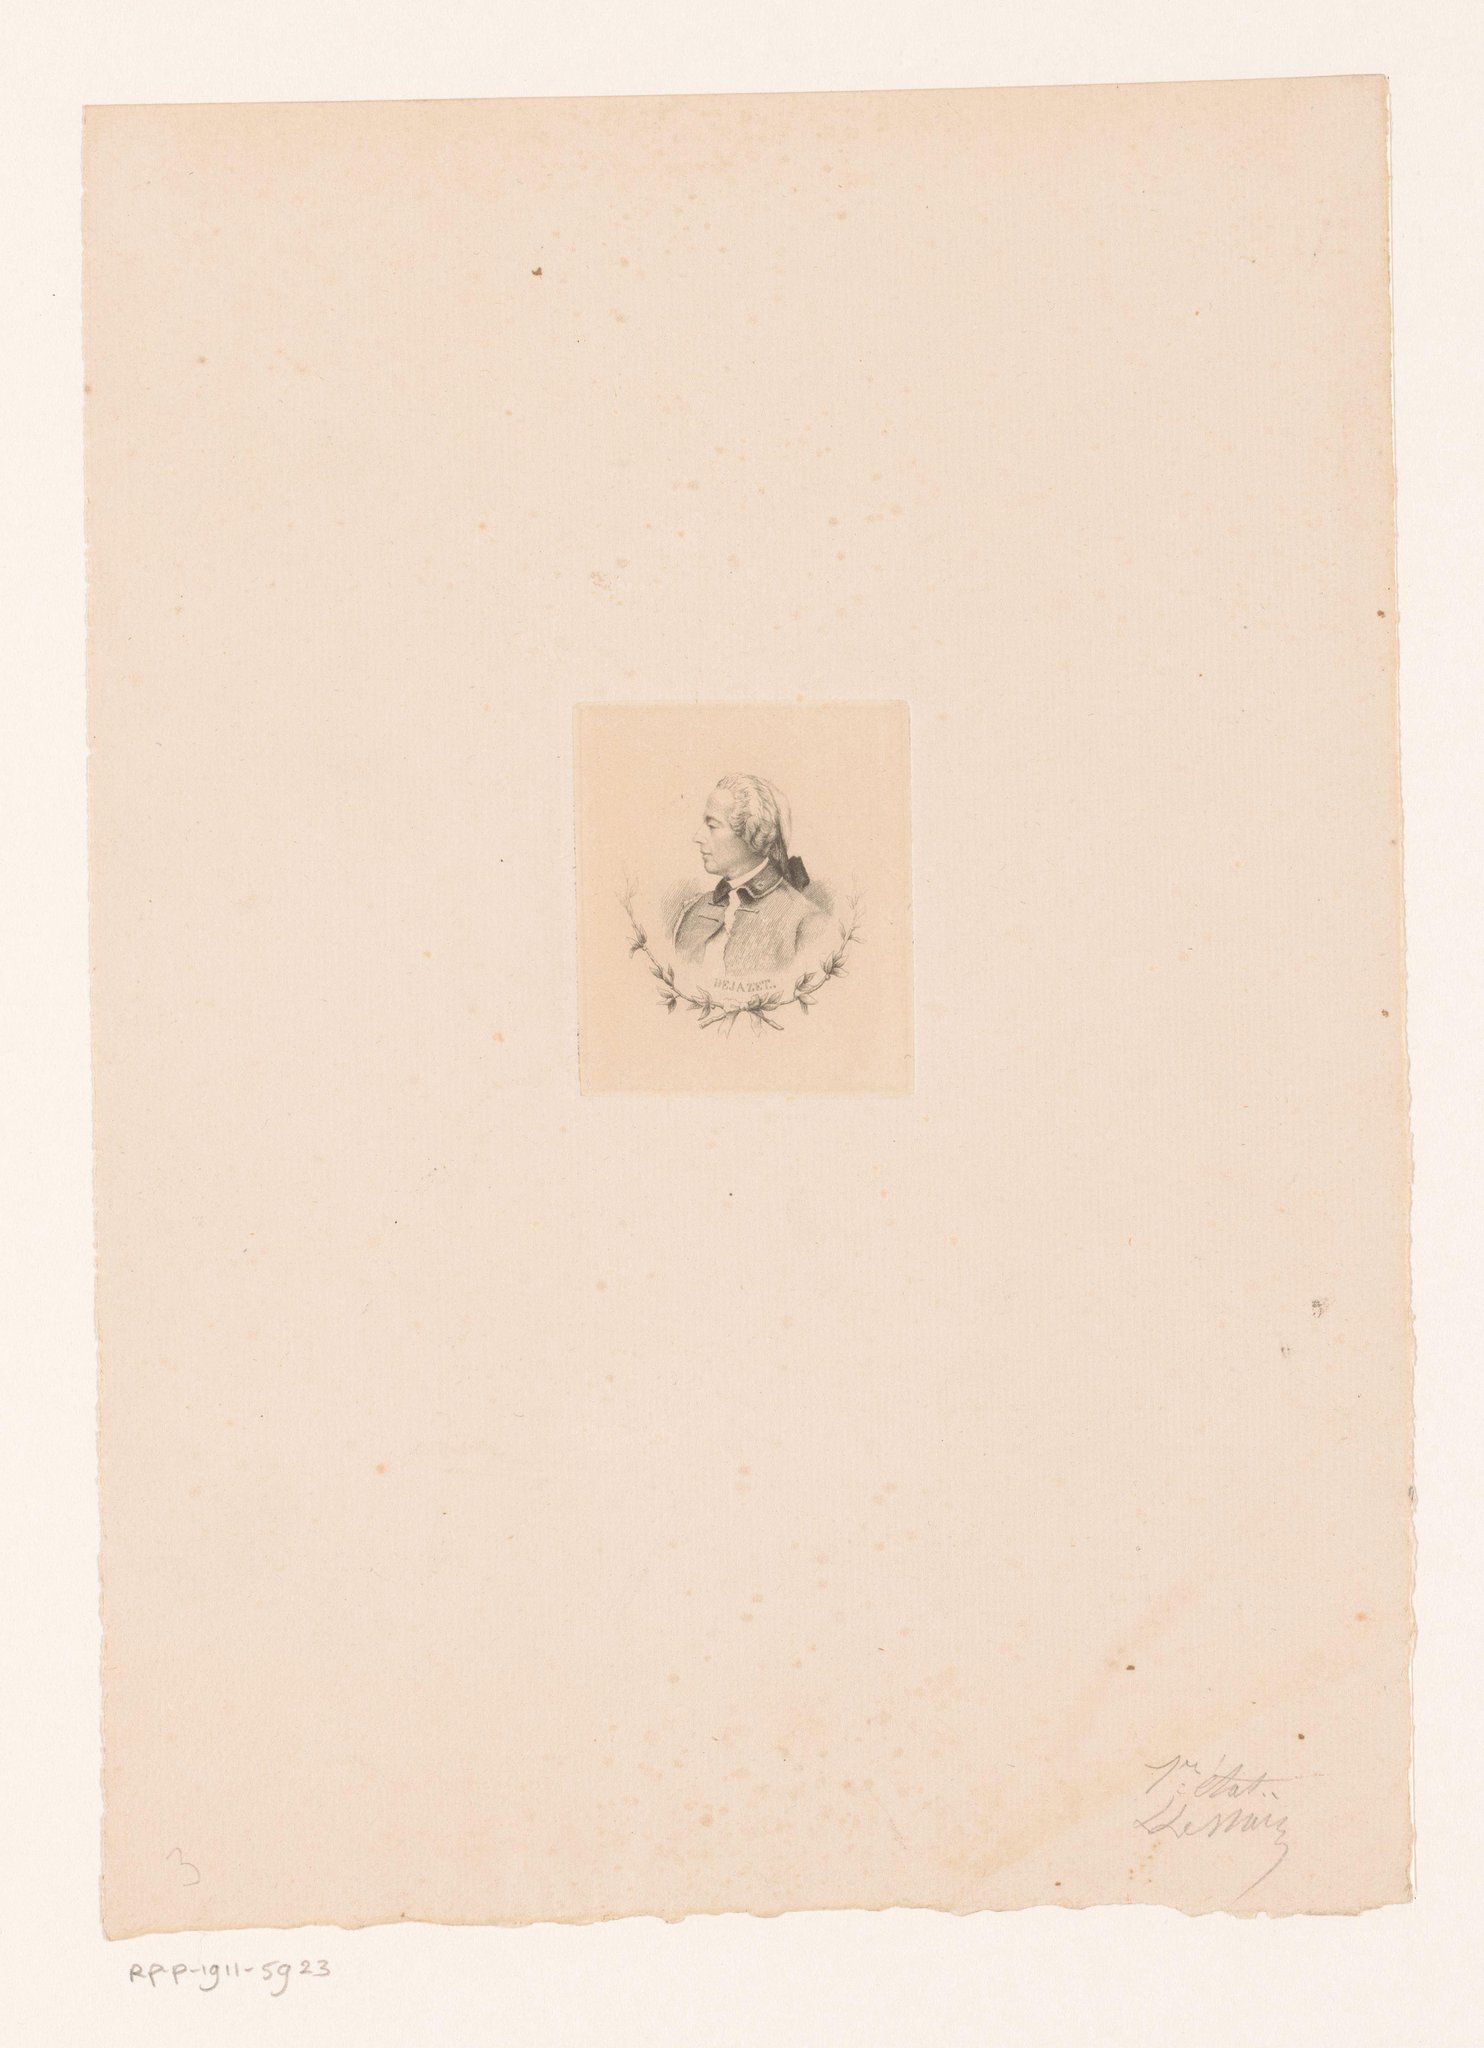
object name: print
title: Portret van een onbekende man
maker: louis le nain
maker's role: print maker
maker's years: 1851-1939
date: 1861-1911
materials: paper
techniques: etching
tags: adult man, historical persons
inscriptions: collector's mark: Lugt 2228, inscription: ‘1e état LLe Nain’